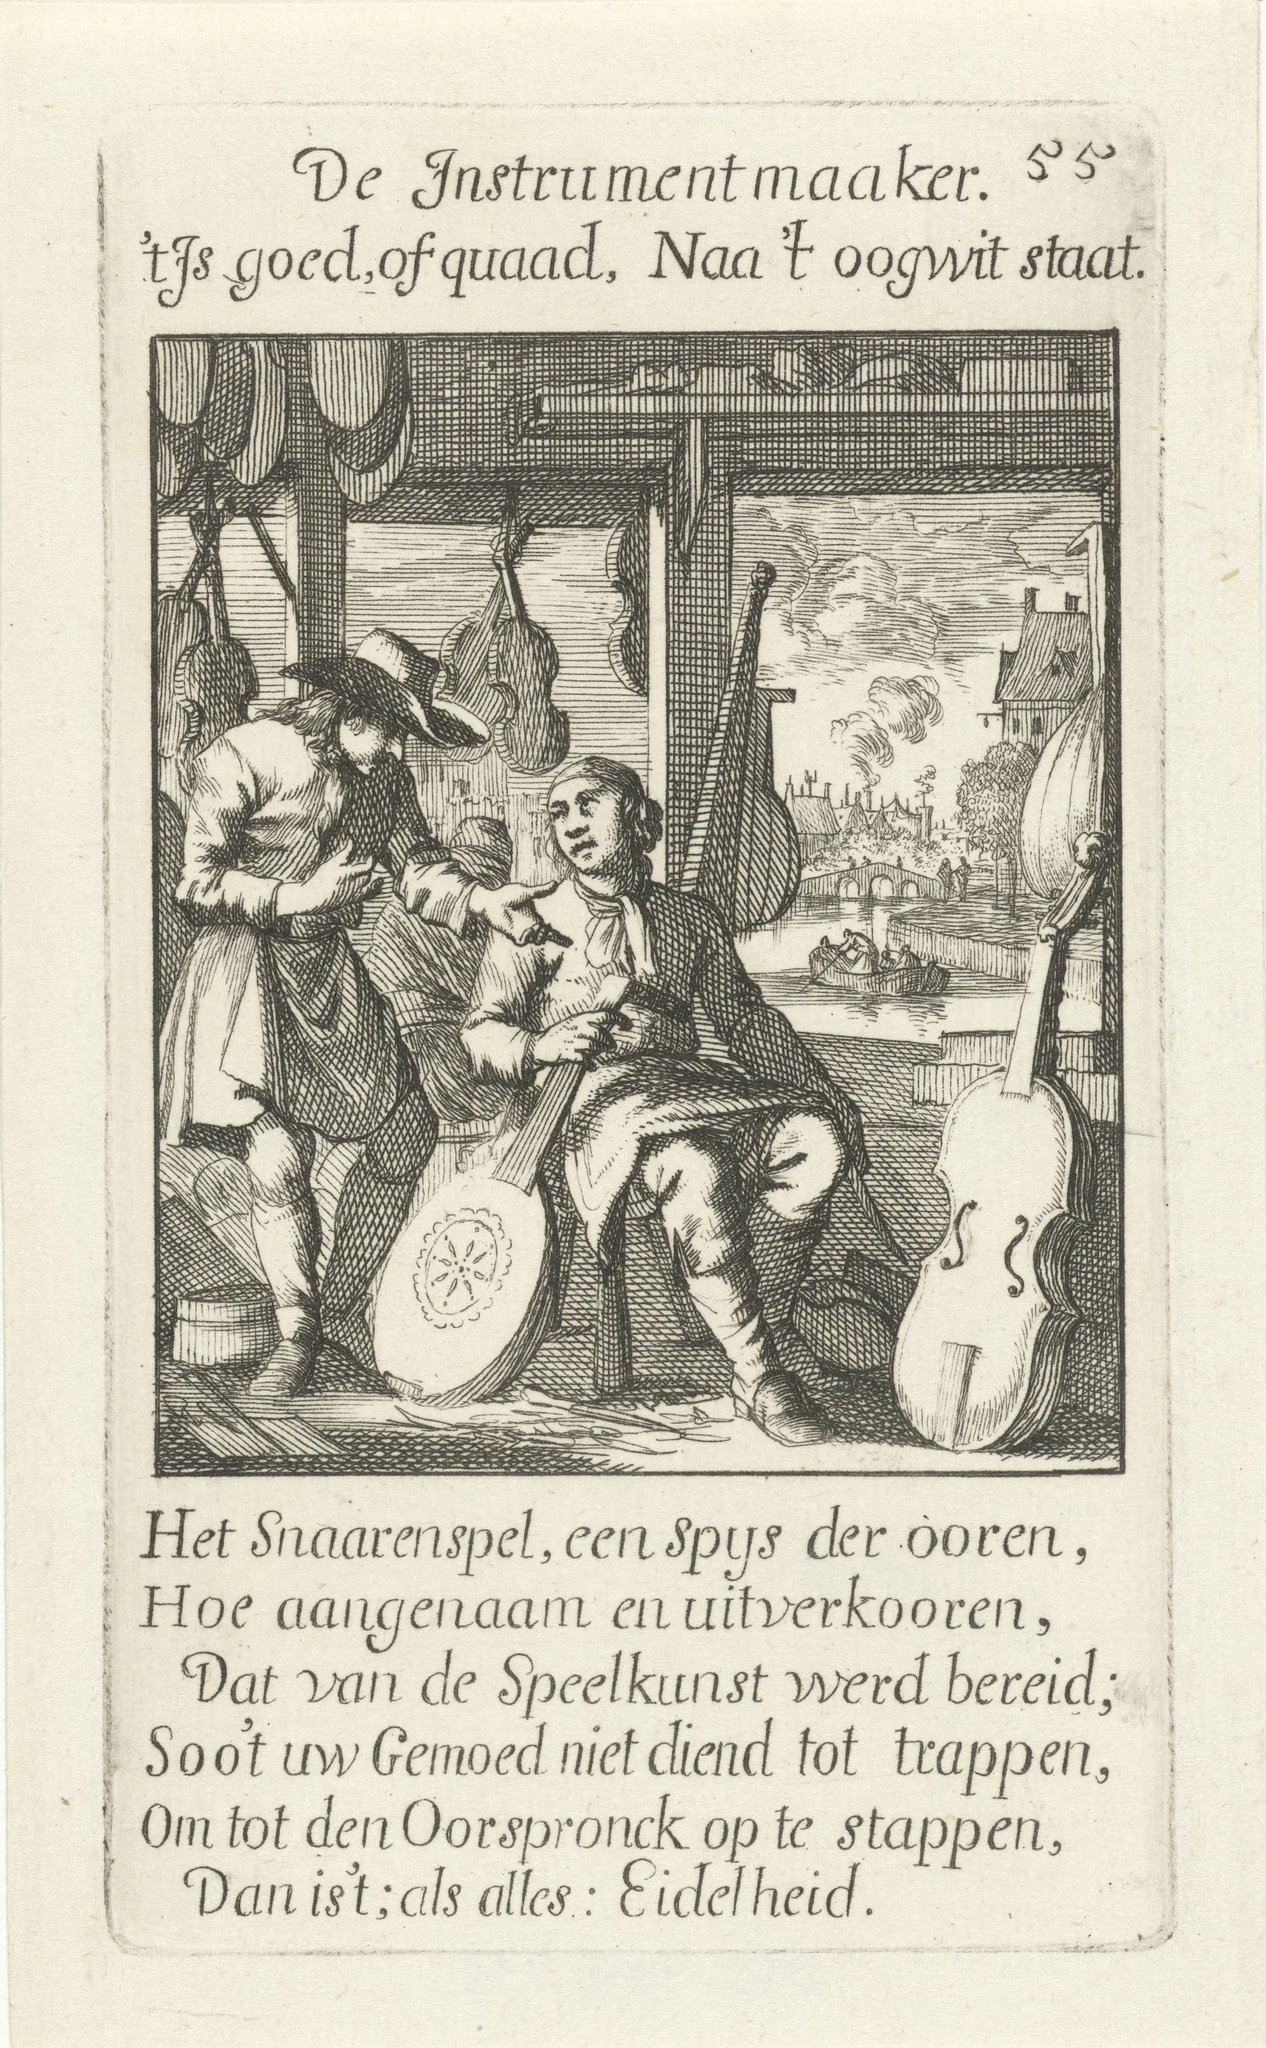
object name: print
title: Instrument Maker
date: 1694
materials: paper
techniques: etching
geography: amsterdam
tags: musical instruments; group of musical instruments, handicrafts, craftsman at work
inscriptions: collector's mark: Lugt 2228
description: In the 17th century, amateur musicians typically played more than one instrument. The rise of amateur musicmaking stimulated the flourishing of a remarkable music market in Dutch society of the time. Many musical instrument makers were active in the country, particularly in Amsterdam. They crafted valuable wind and string instruments, including flutes, oboes, viols,and violins.